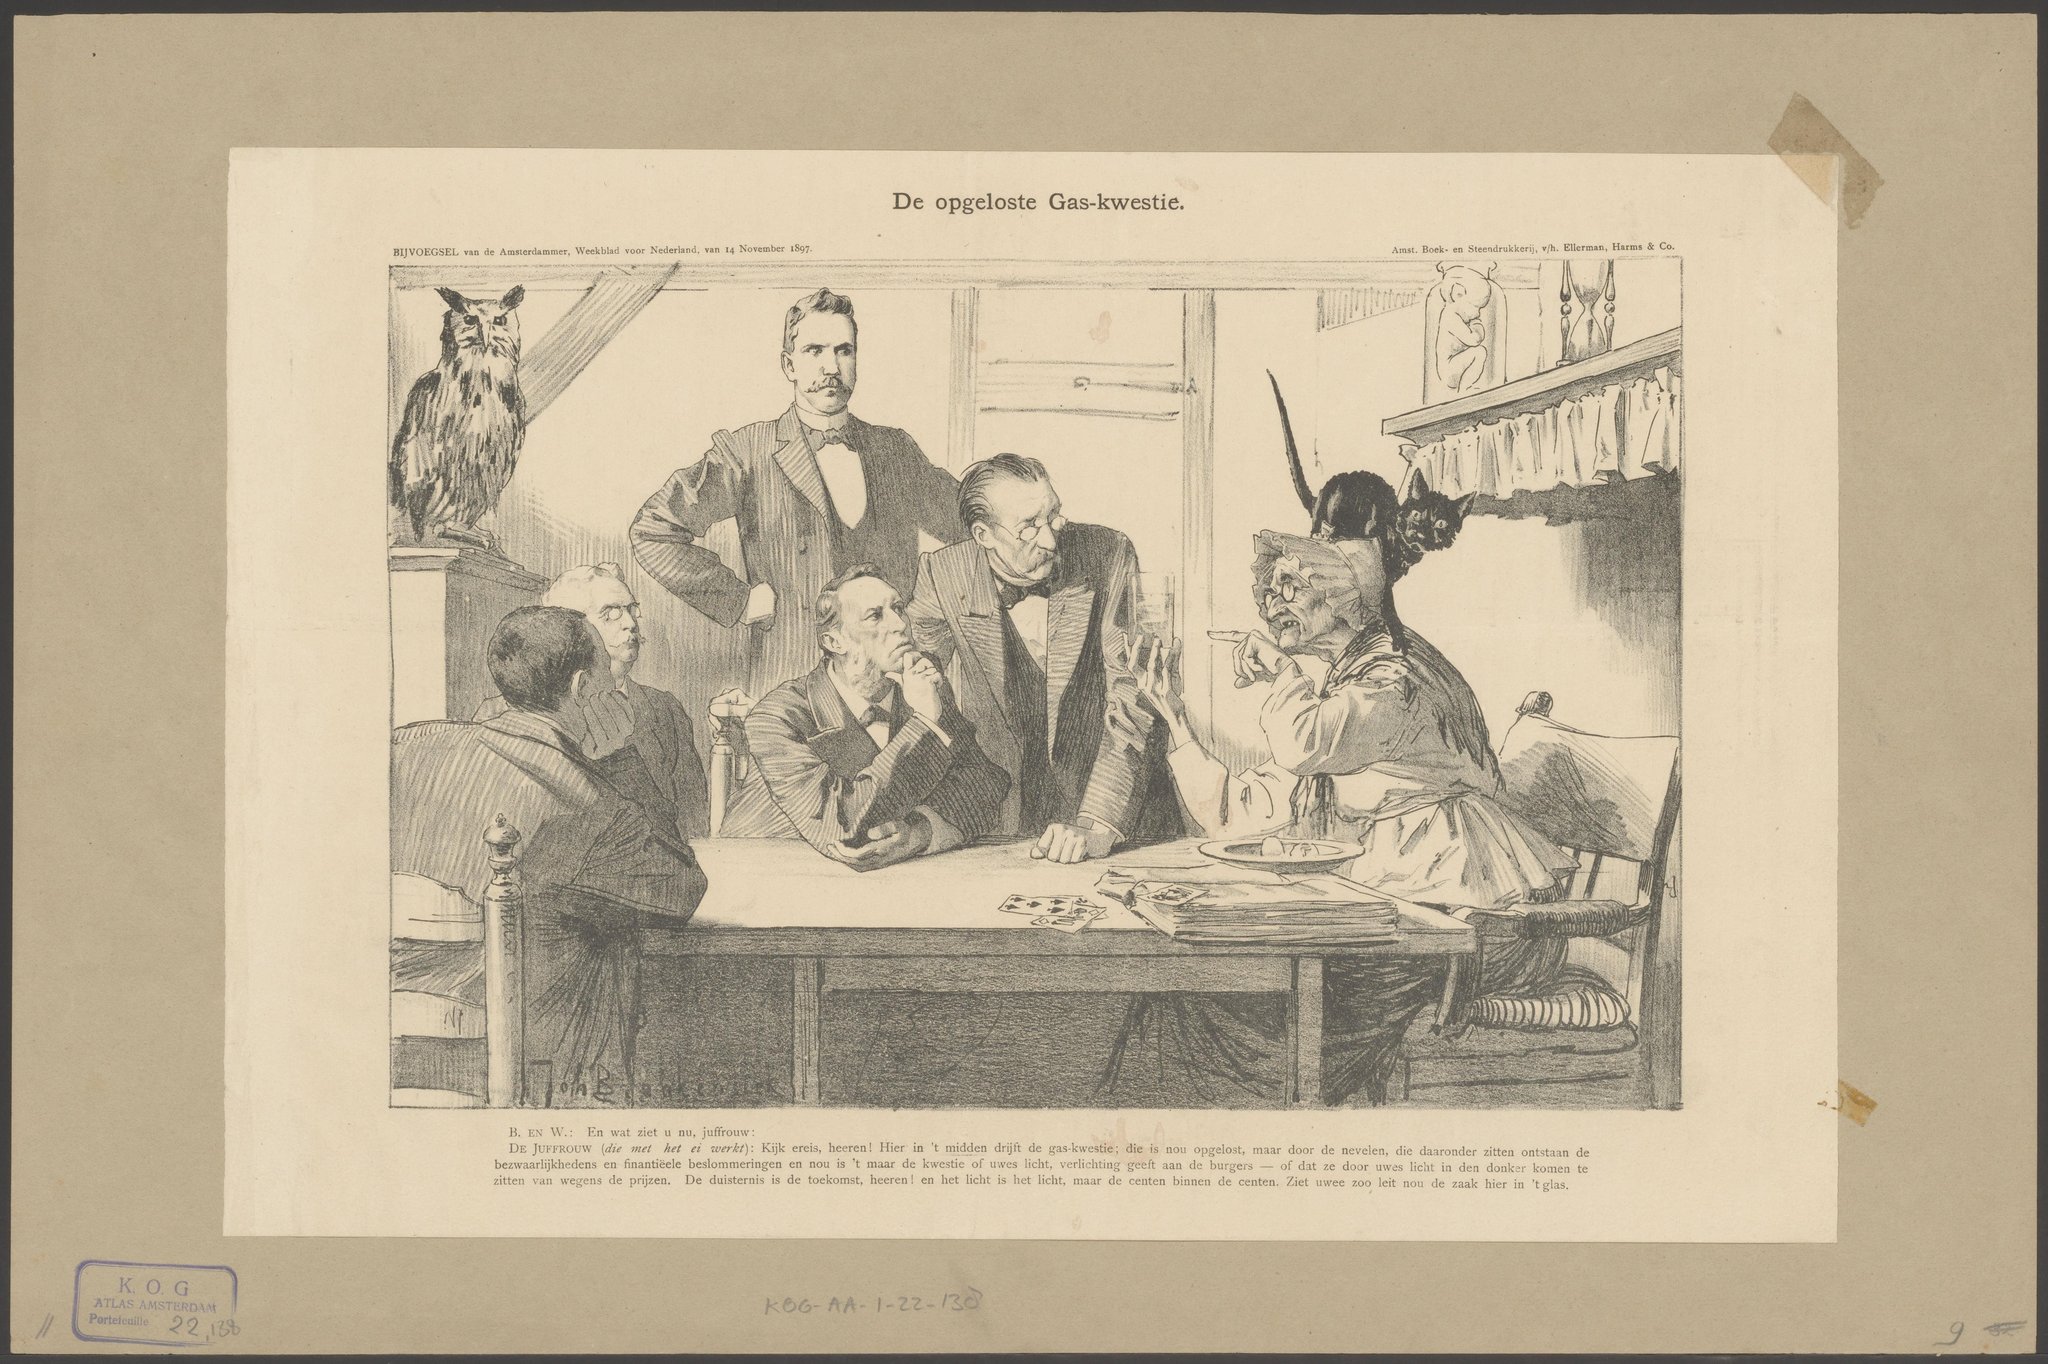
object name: cartoon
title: De opgeloste Gas-kwestie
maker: johan braakensiek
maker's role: draughtsman, print maker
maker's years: 1858-1940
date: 1897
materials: paper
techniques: letterpress printing, lithograph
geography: amsterdam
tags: harlingen, cat, owls, fortune-teller ~ pleasure fair and circus - aa - fortune-teller (female), political caricatures and satires, amsterdam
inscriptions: collector's mark: Lugt 1641b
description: Gepubliceerd als bijvoegsel van 'De Amsterdammer', 14 november 1897.